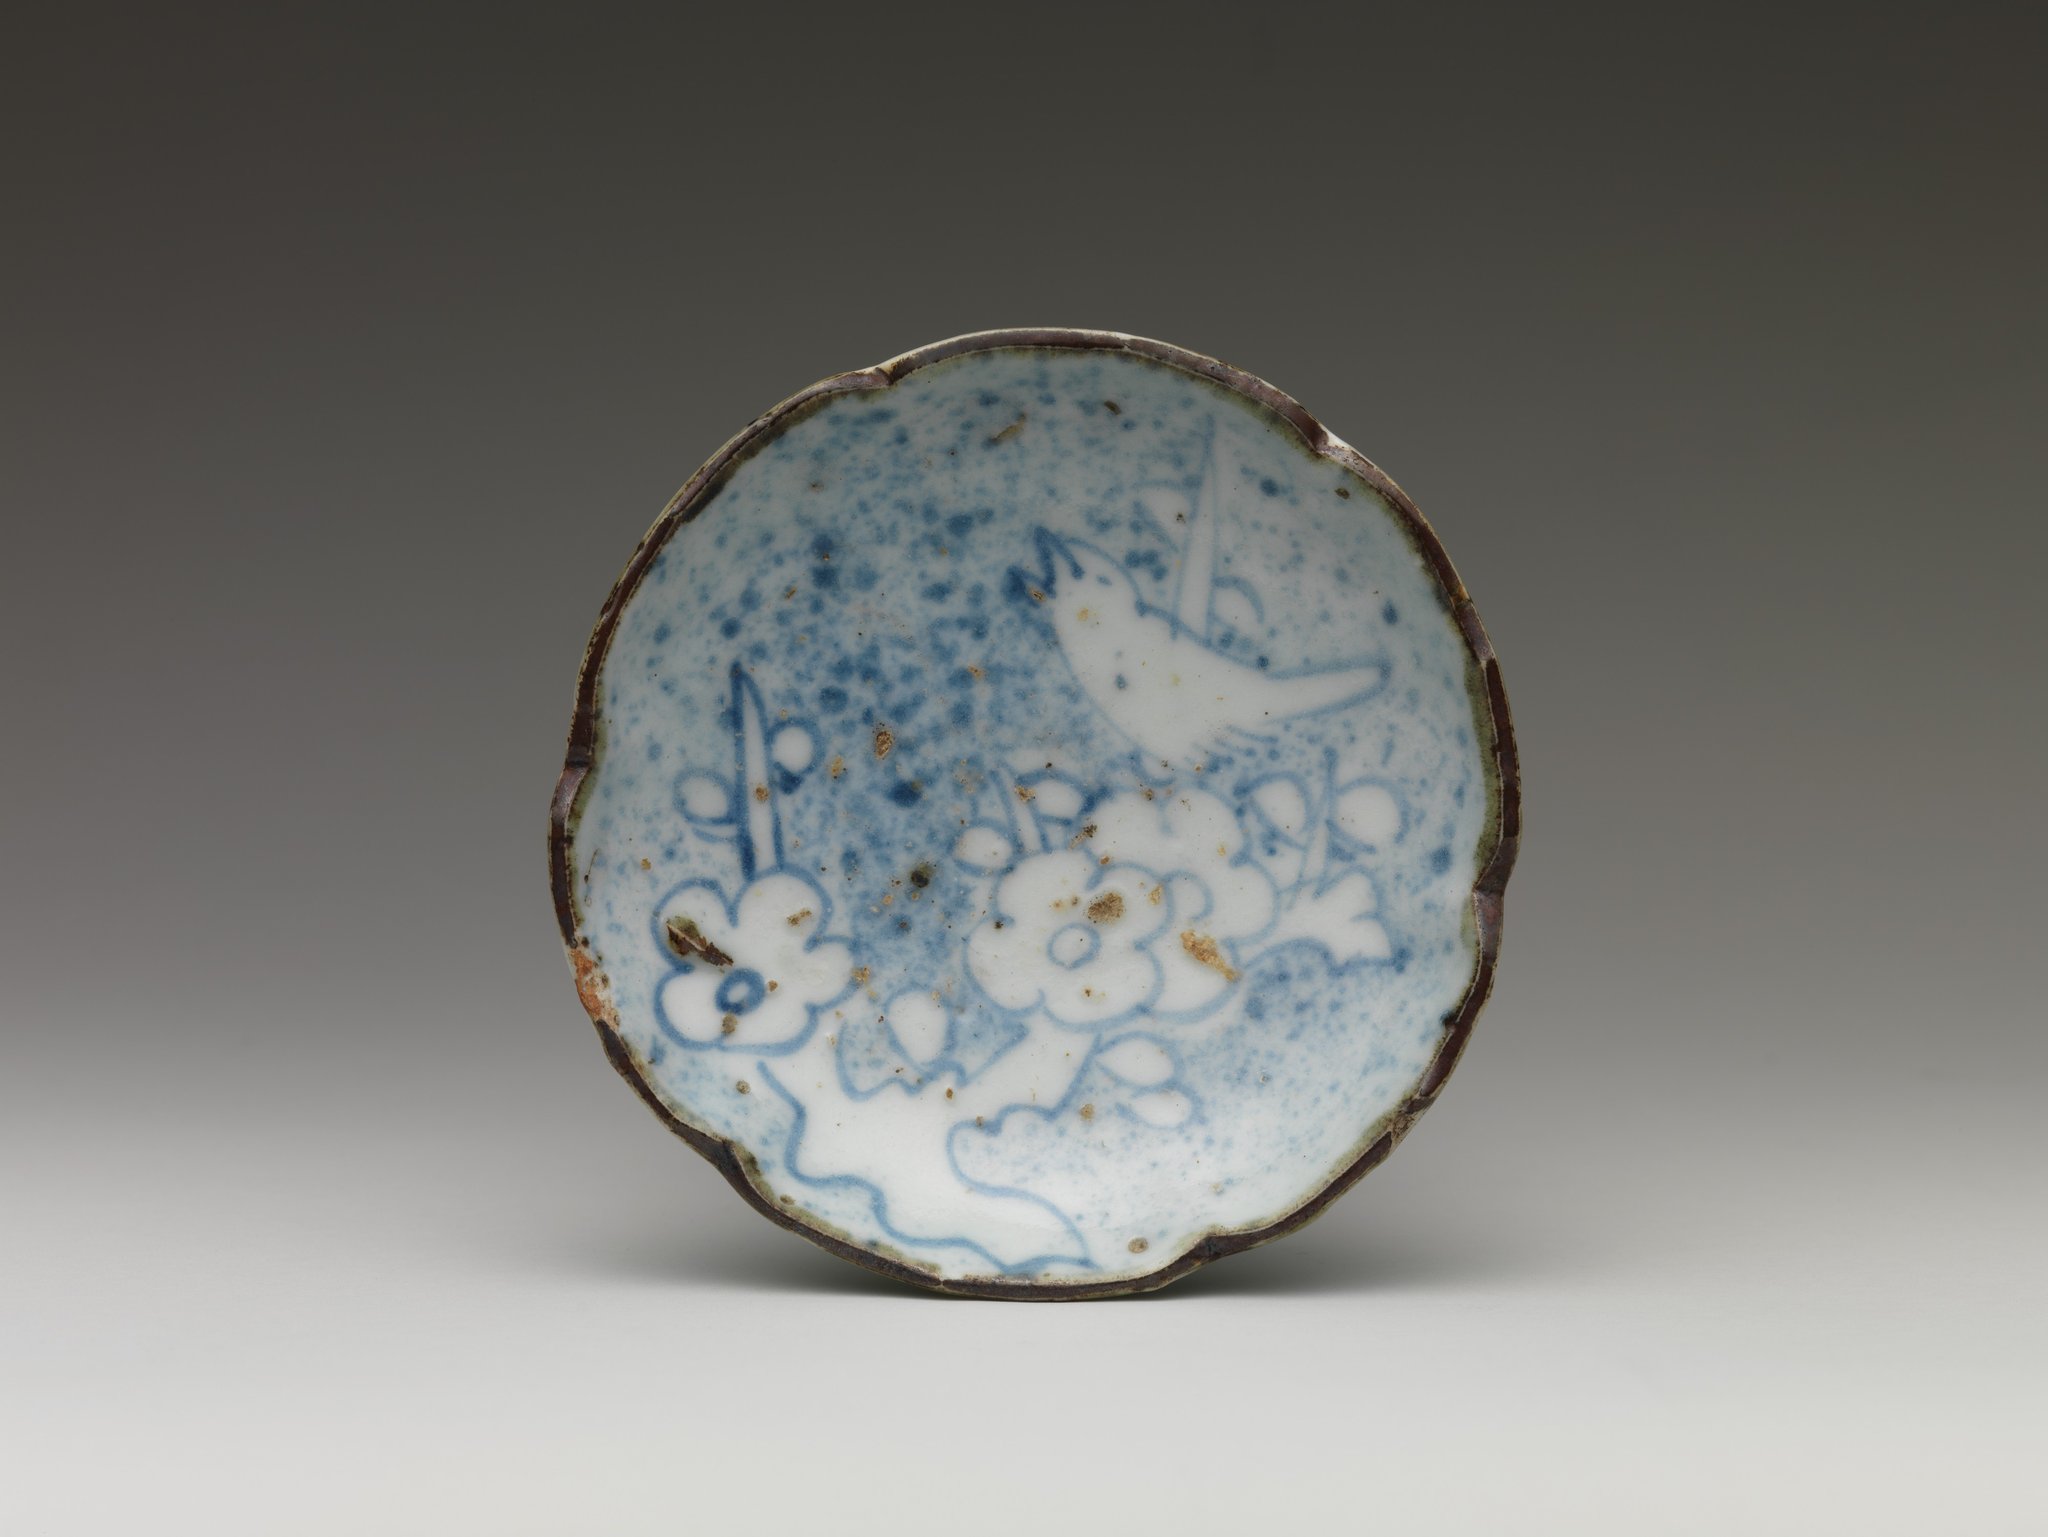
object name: dish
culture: japanese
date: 1640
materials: porcelain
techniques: underglaze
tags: birds,flowers